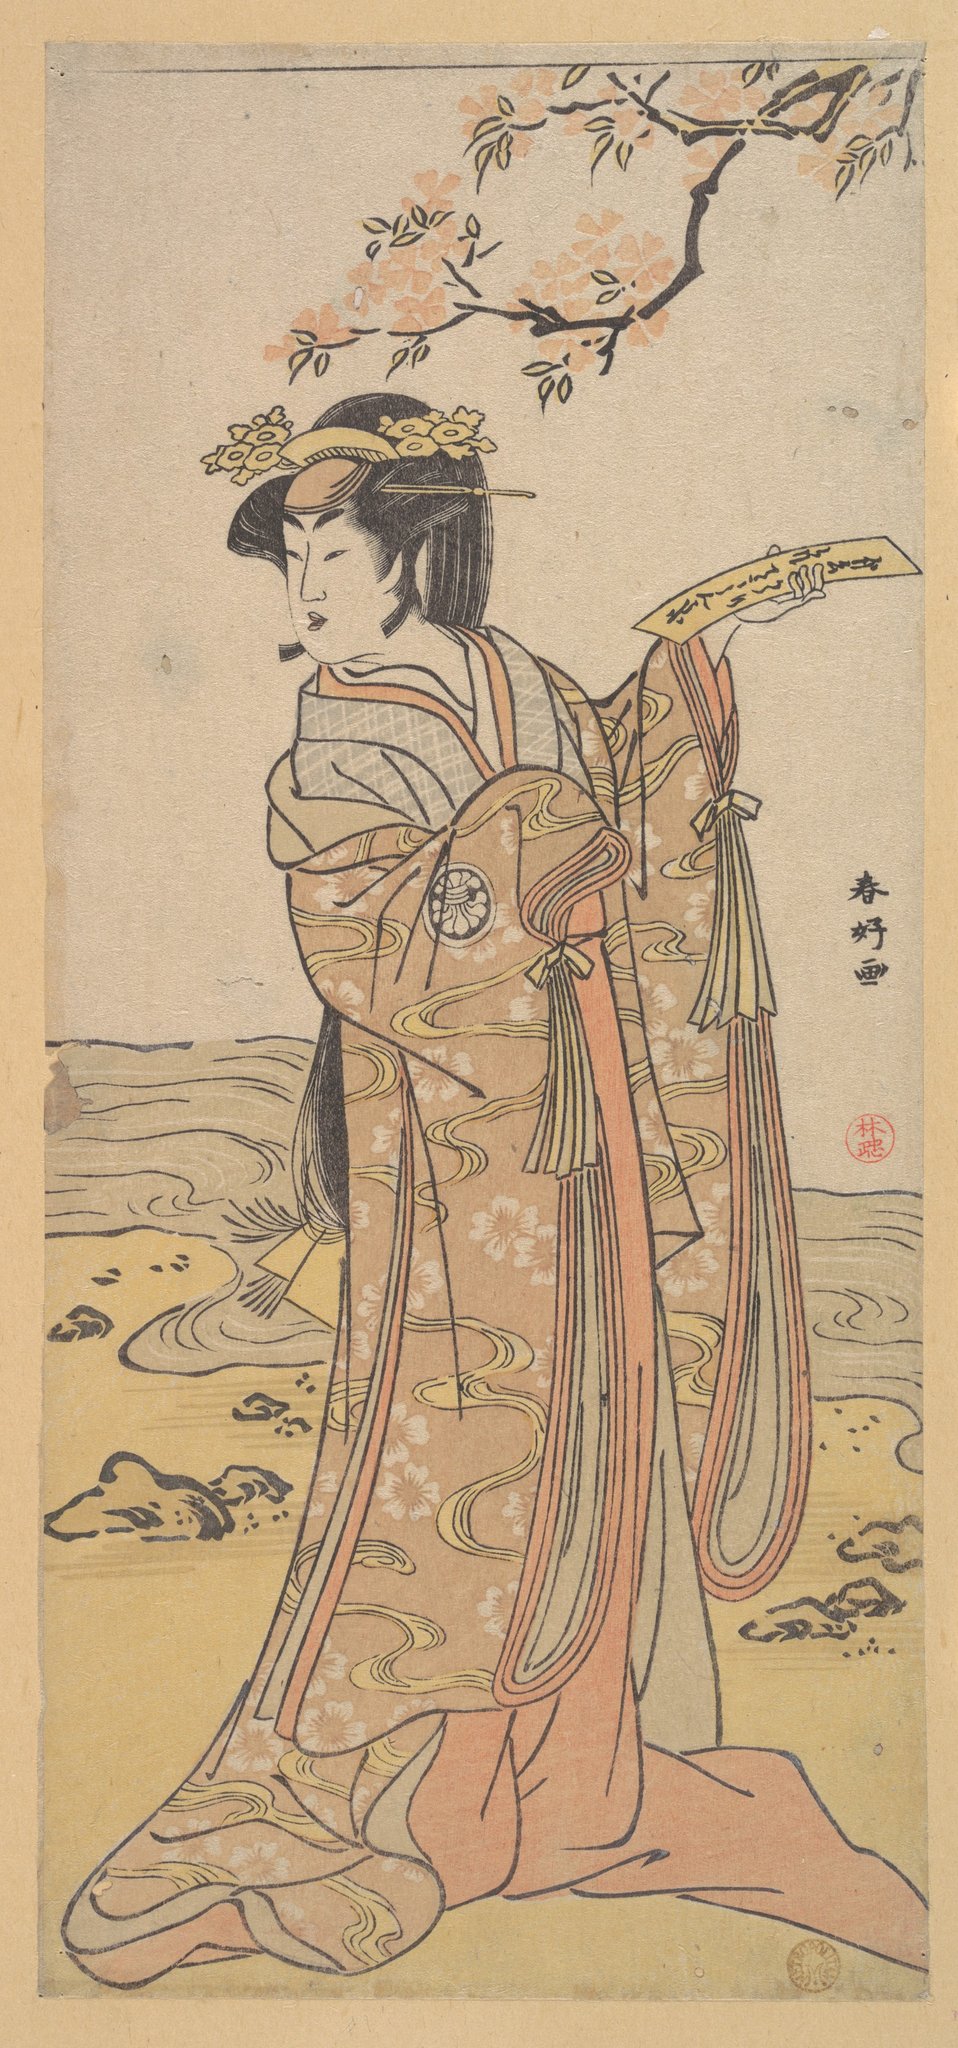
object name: print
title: The Third Segawa Kikunojo as a Woman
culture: japanese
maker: katsukawa shunkō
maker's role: artist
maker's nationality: japanese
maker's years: 1743-1812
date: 1780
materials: ink, paper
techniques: woodblock print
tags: women,trees